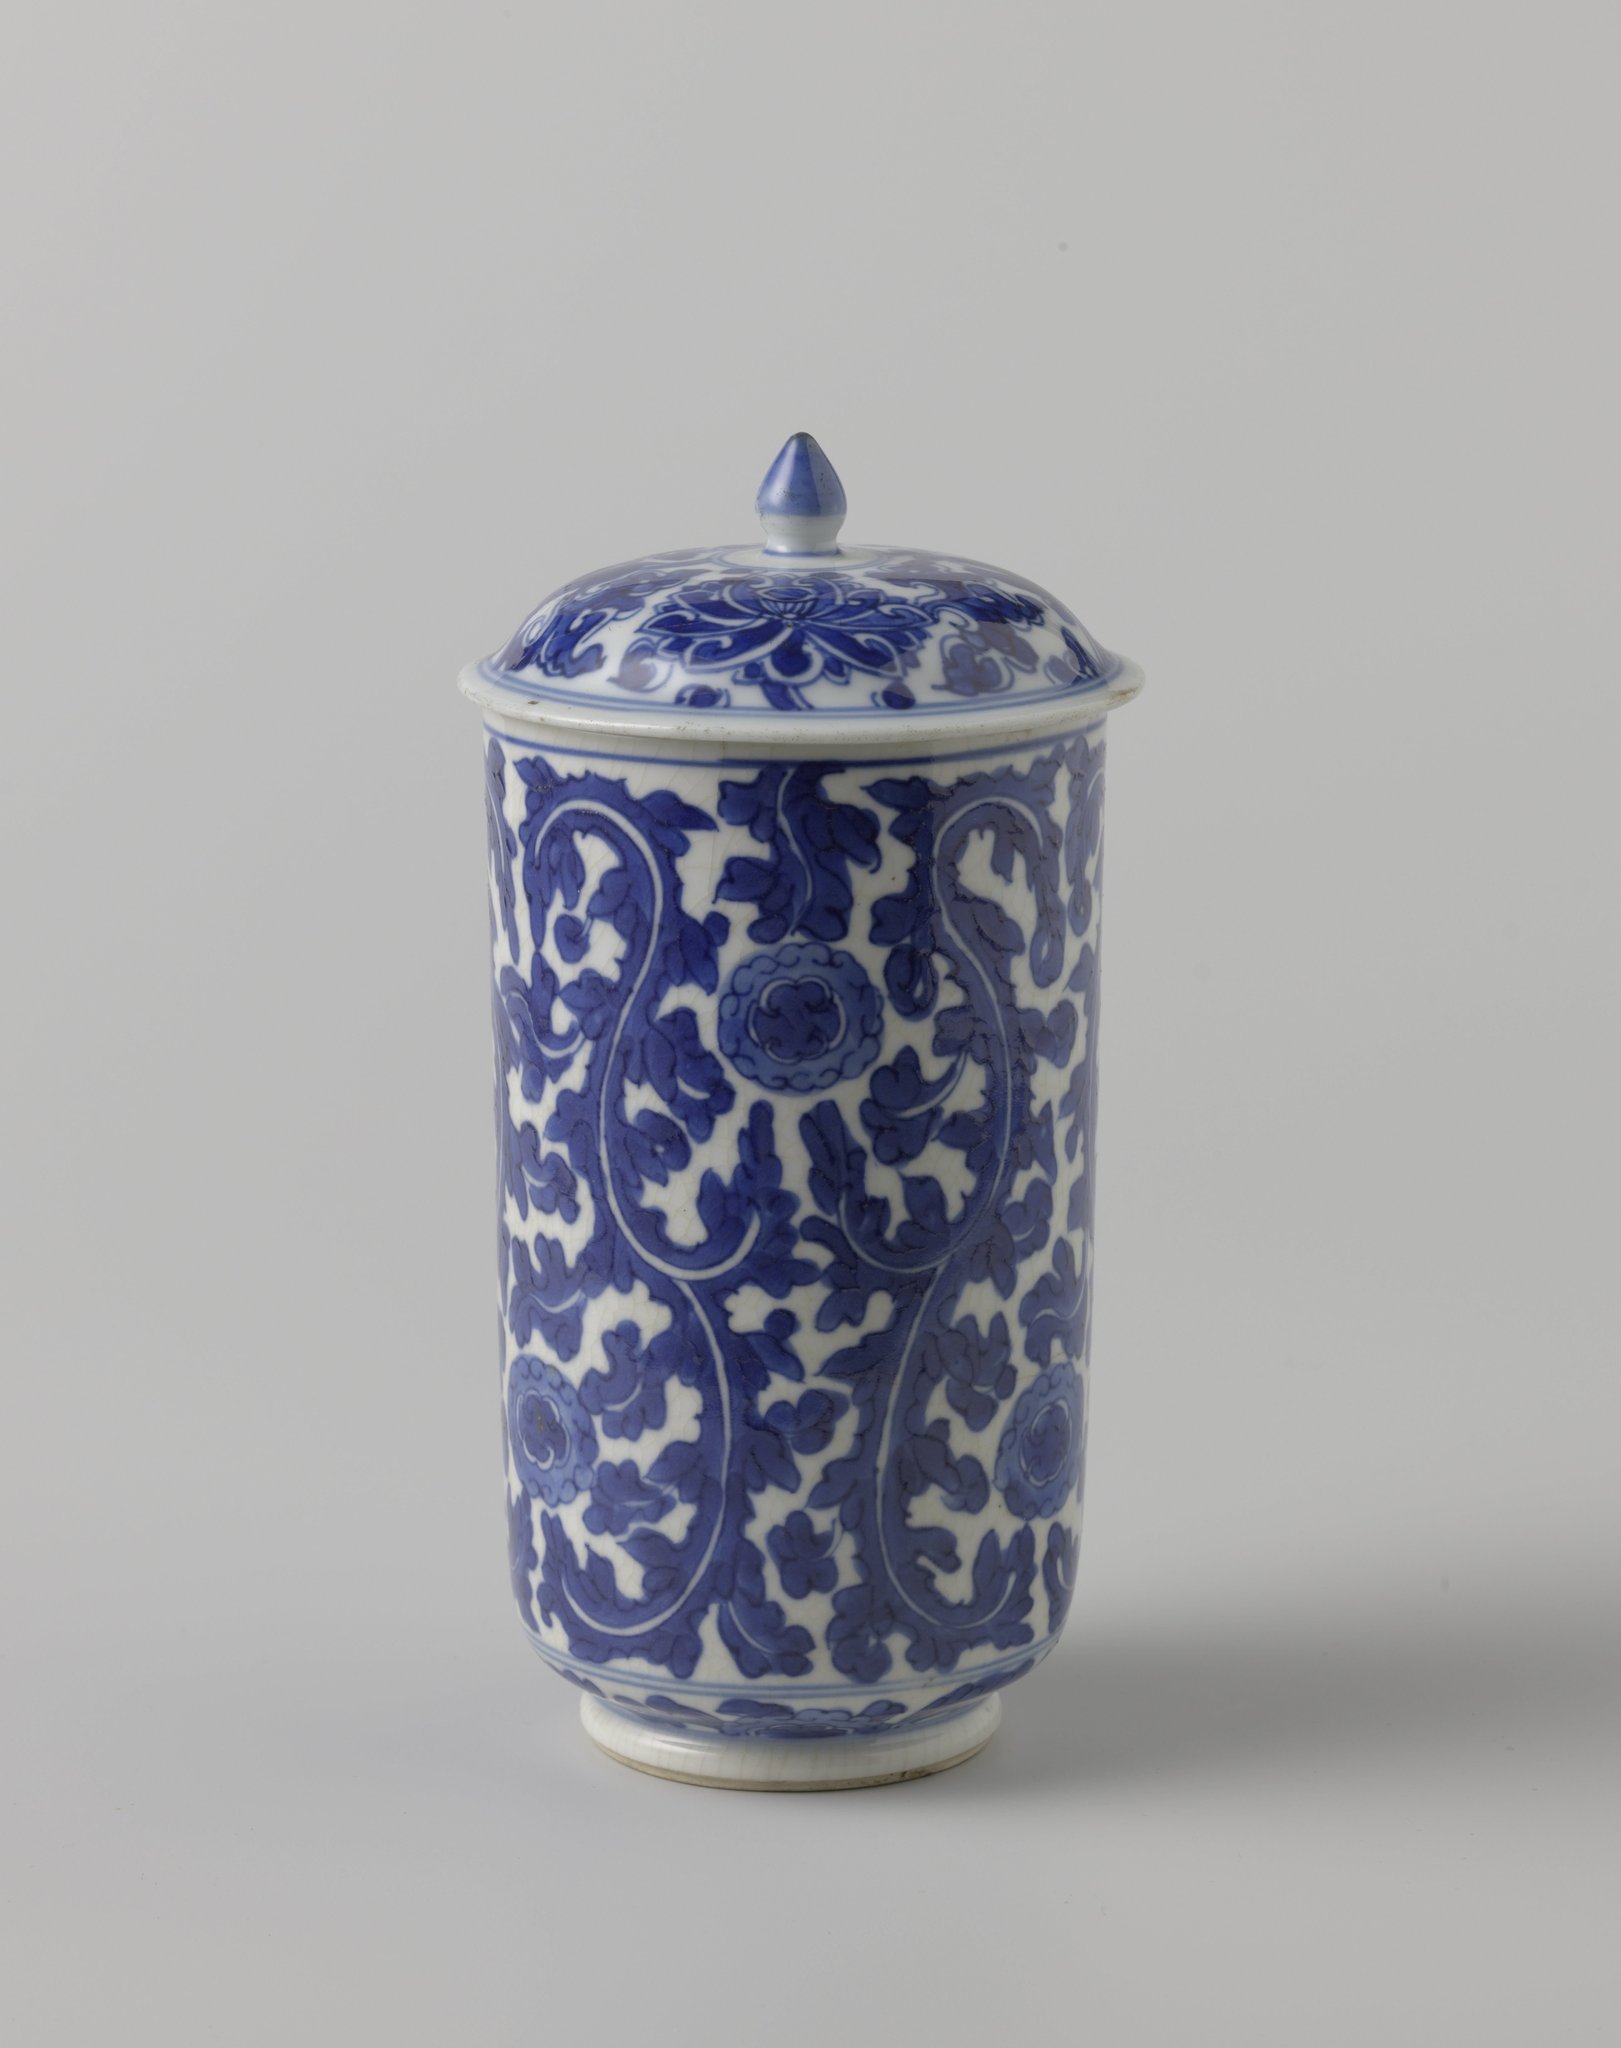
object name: pot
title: Covered cylindrical beaker with leaf-motif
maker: Anonymous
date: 1680-1720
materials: cobalt, glaze, paint, porcelain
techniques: firing, turning, vitrification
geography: china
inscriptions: mark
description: Cilindrische beker van porselein, beschilderd in onderglazuur blauw. Versierd met een doorlopend, krullend bladmotief afgewisseld met bloemrozetten (tijgerlelie-motief). Gemerkt op de onderzijde met een artemisiablad in een dubbele cirkel. Blauw-wit.